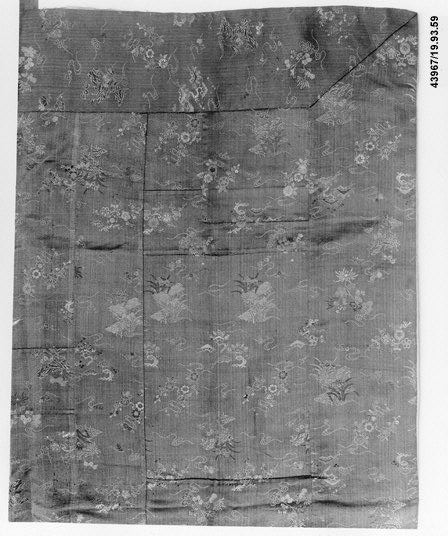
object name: robe, priest's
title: Priest's Robe (Shichijō)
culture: japanese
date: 1655-1658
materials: silk